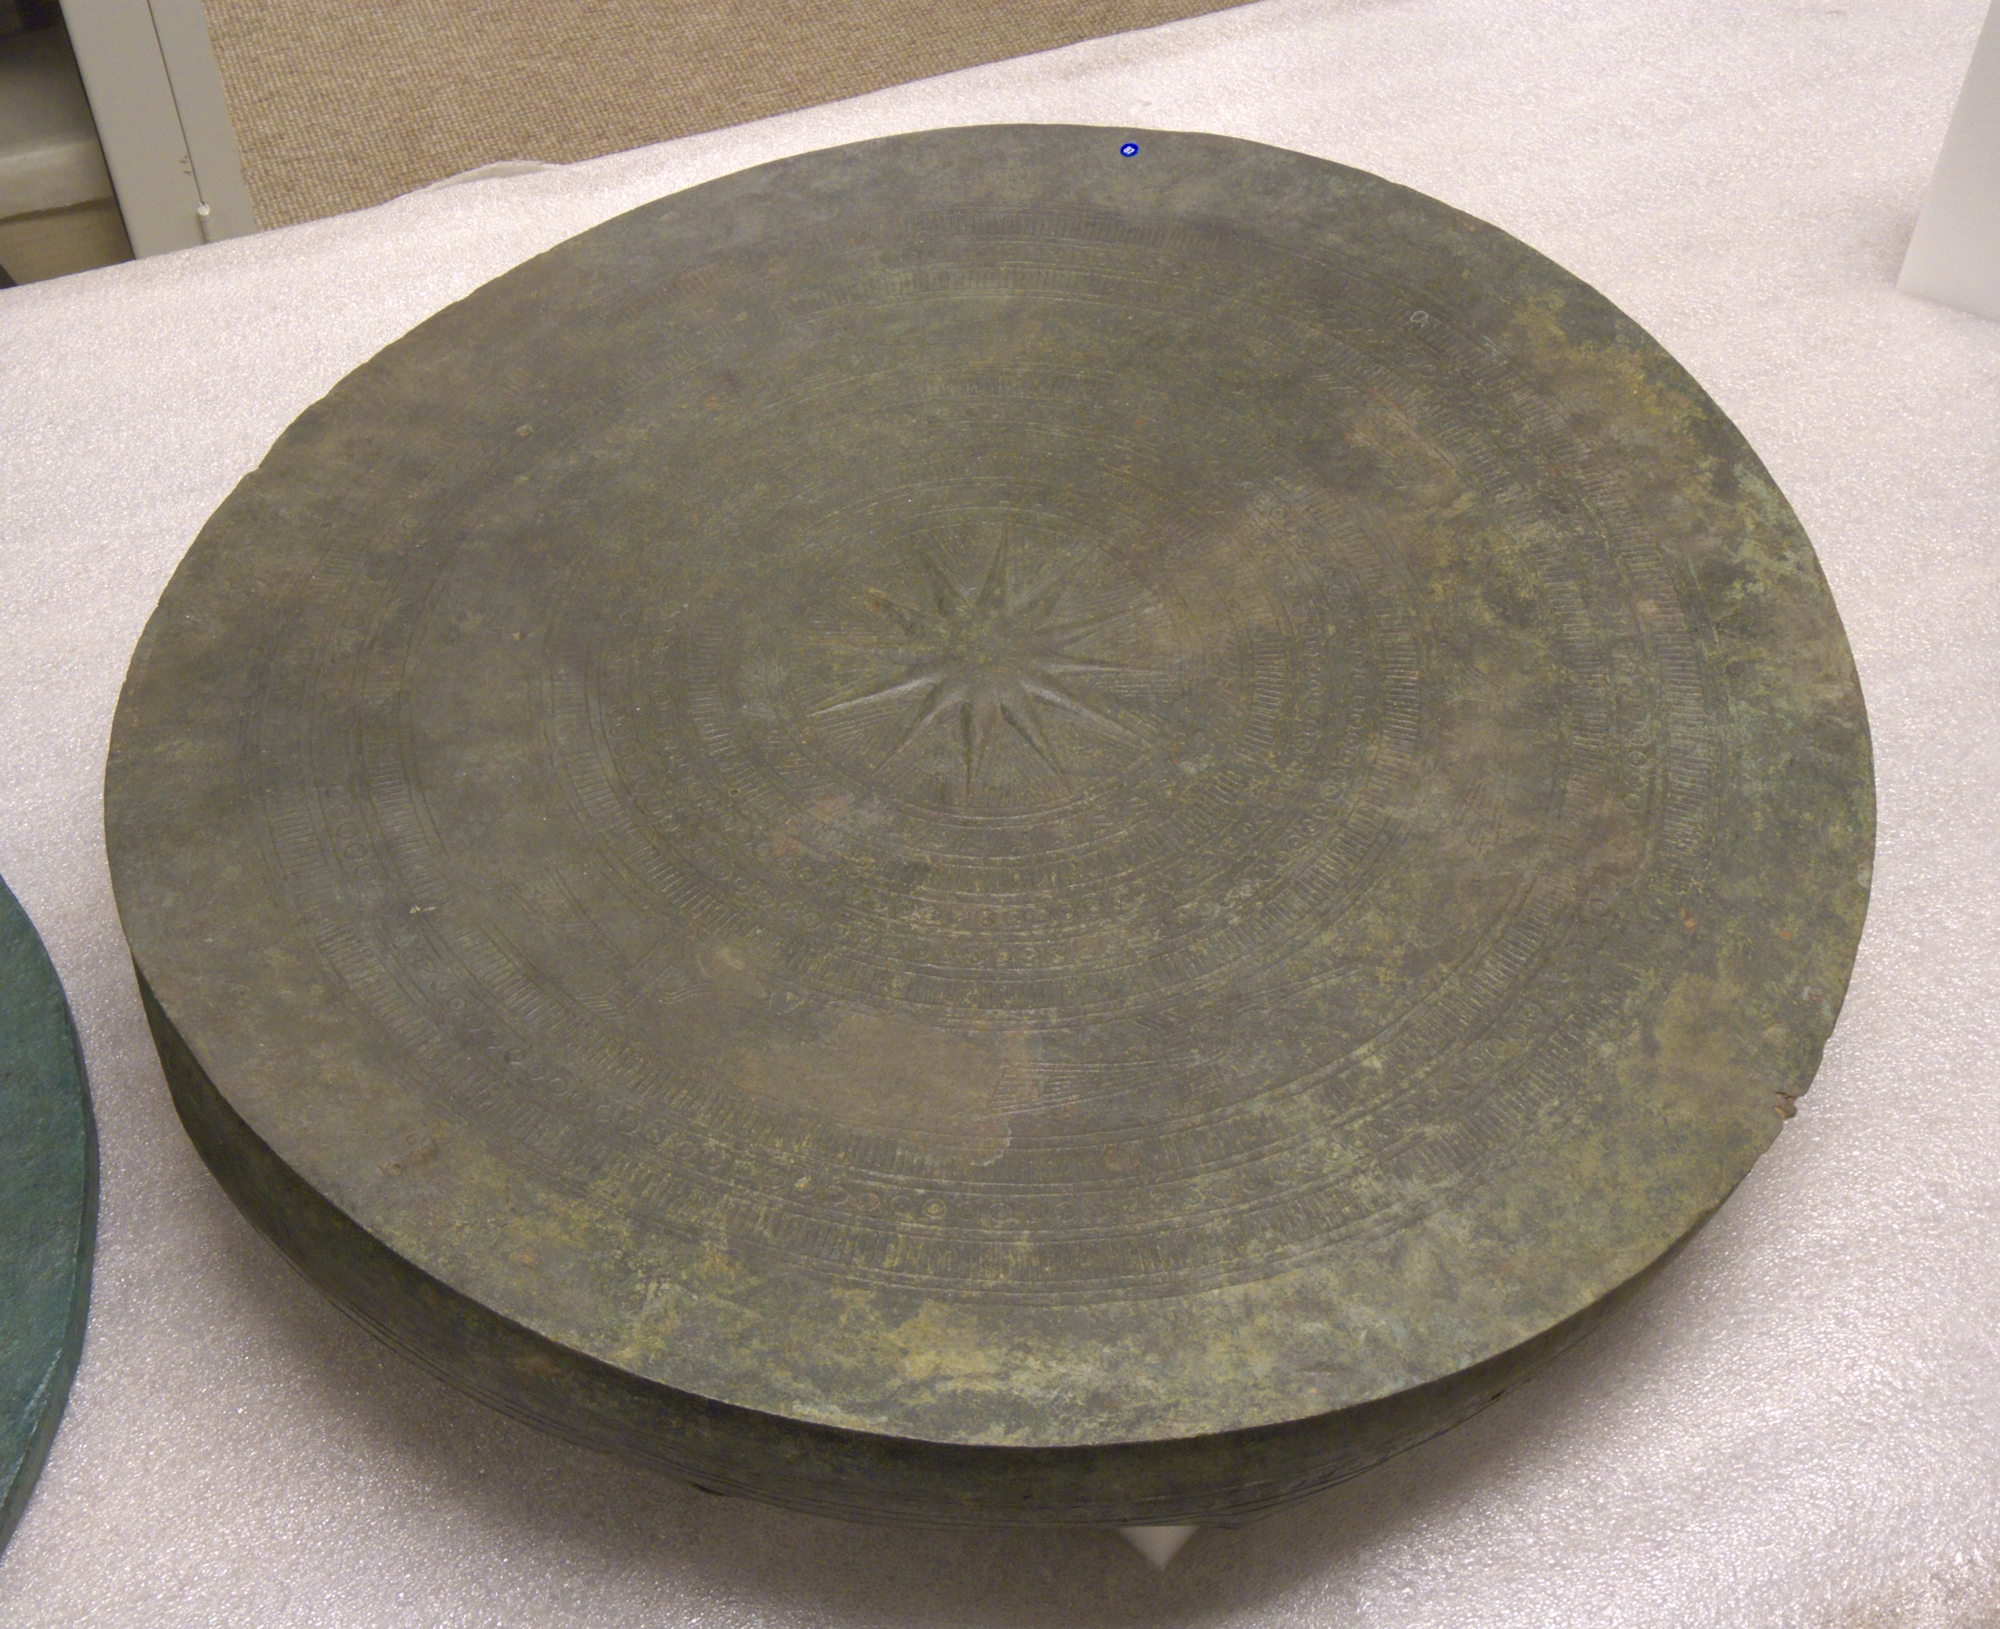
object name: drum tympanum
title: Drum Tympanum with Star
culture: vietnamese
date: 500 BCE-300 CE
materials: bronze